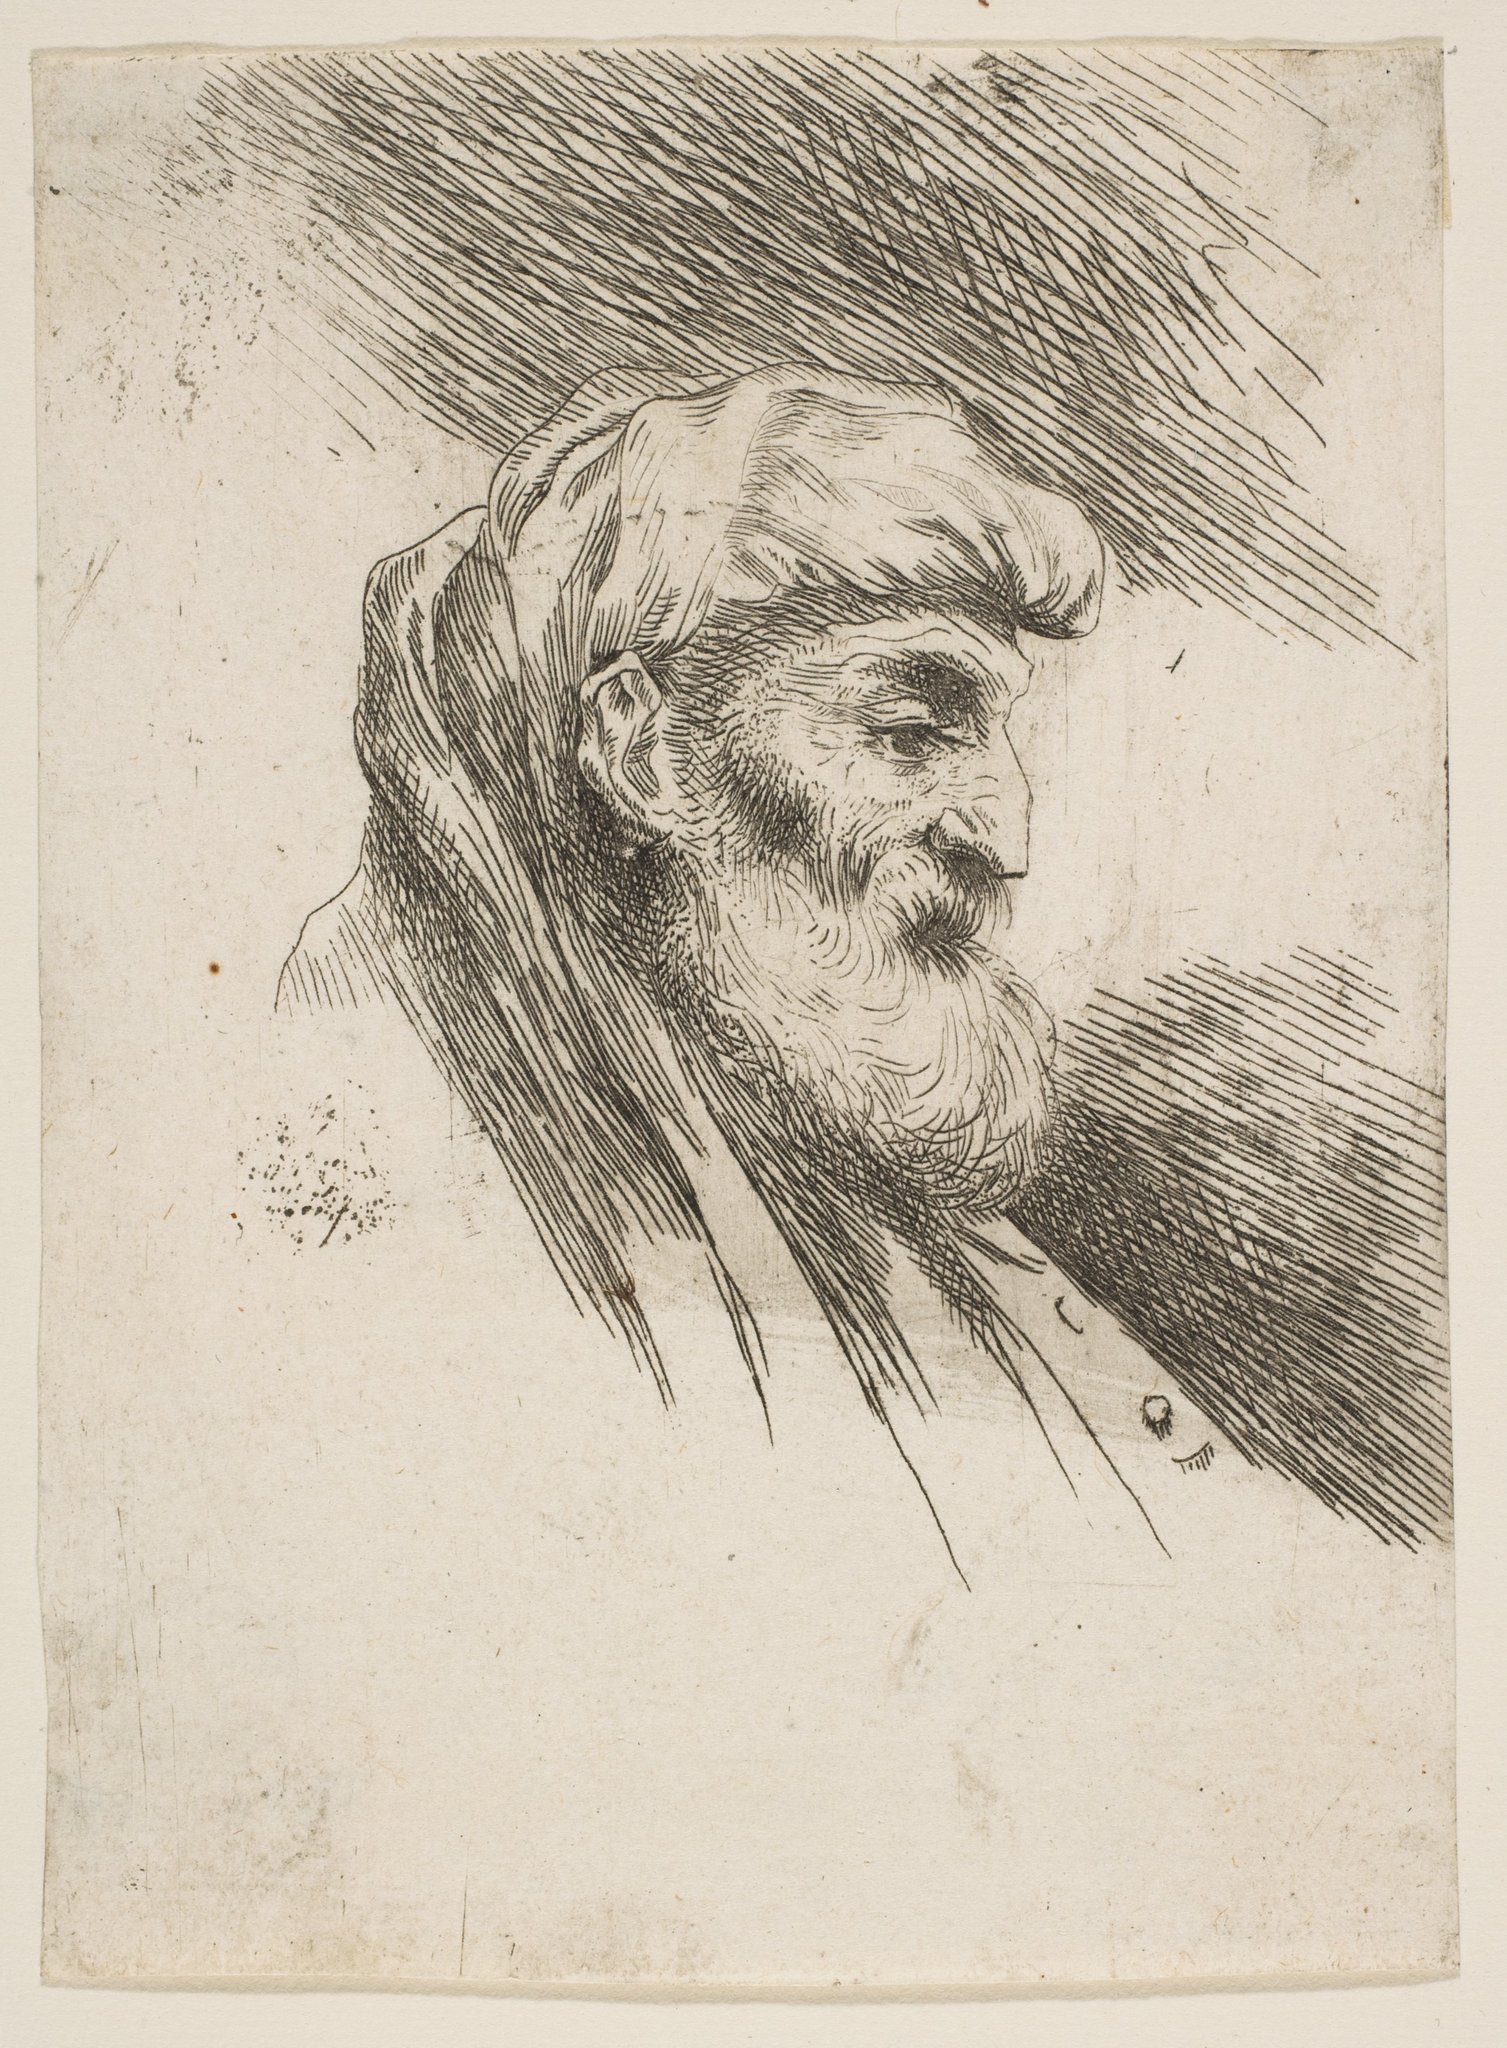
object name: print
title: Head of an old bearded man facing right, from "Small Heads in Oriental Headdress"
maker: giovanni benedetto castiglione (il grechetto)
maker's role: artist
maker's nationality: italian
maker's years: 1609-1664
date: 1645-1650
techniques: etching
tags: men